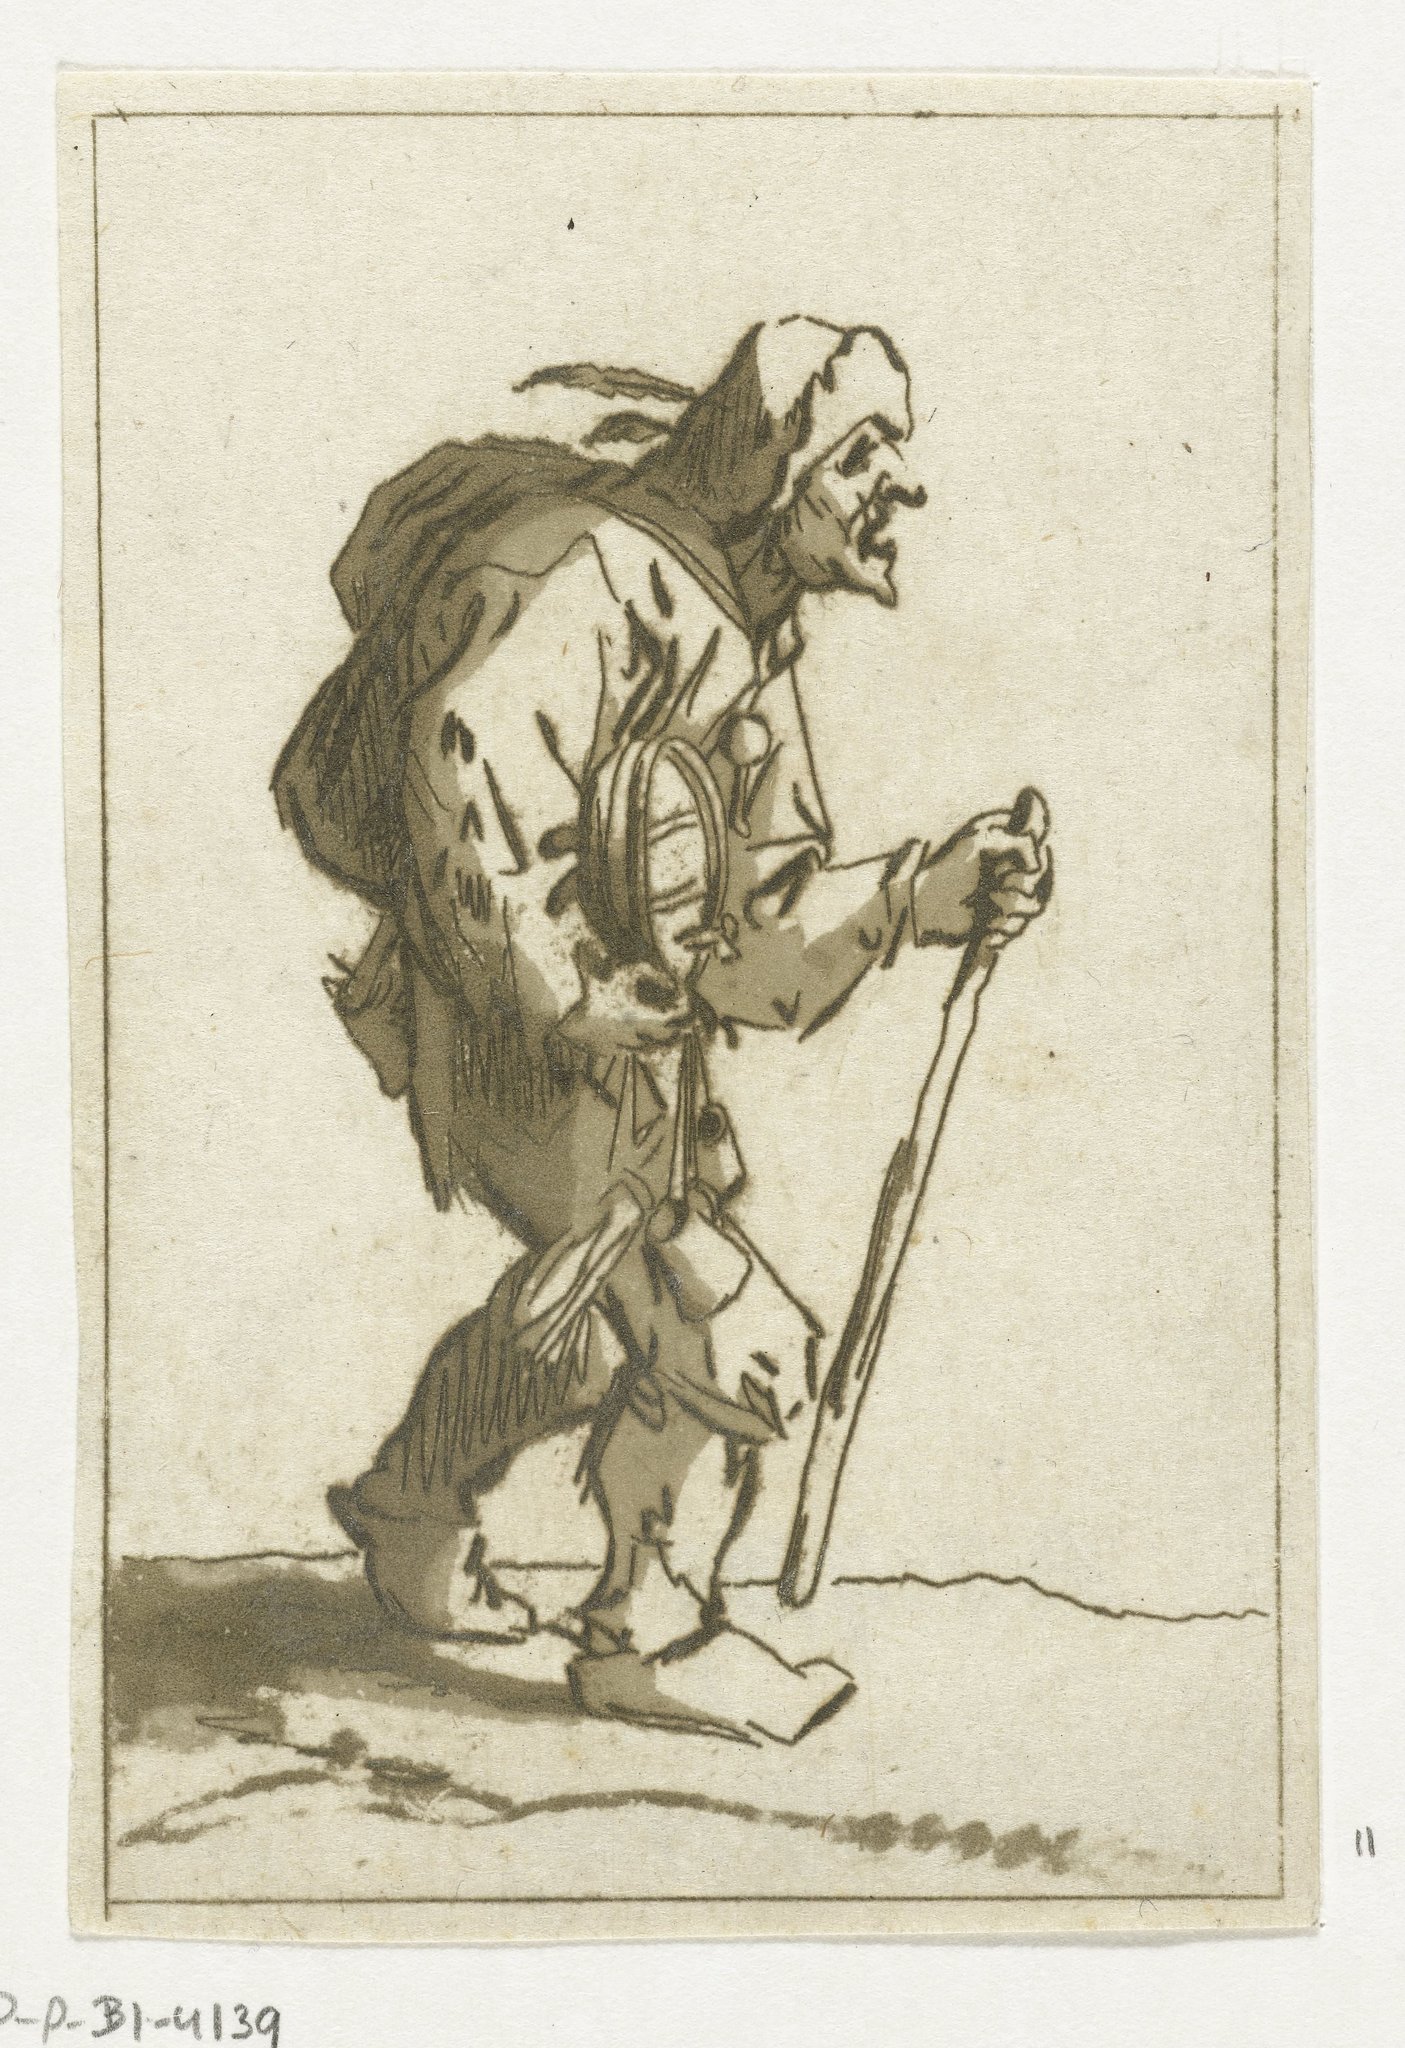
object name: print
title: Inkt- en pennenkoopman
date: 1778-1838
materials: paper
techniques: aquatint, etching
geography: netherlands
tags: ink-well, street-trader, beggar, pencil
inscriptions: collector's mark: Lugt 2228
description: Een koopman lopend met een stok in zijn hand. Hij heeft een vaatje onder zijn rechterarm, en houdt met zijn rechterhand inktkokers en pennen vast, die aan een koord hangen.